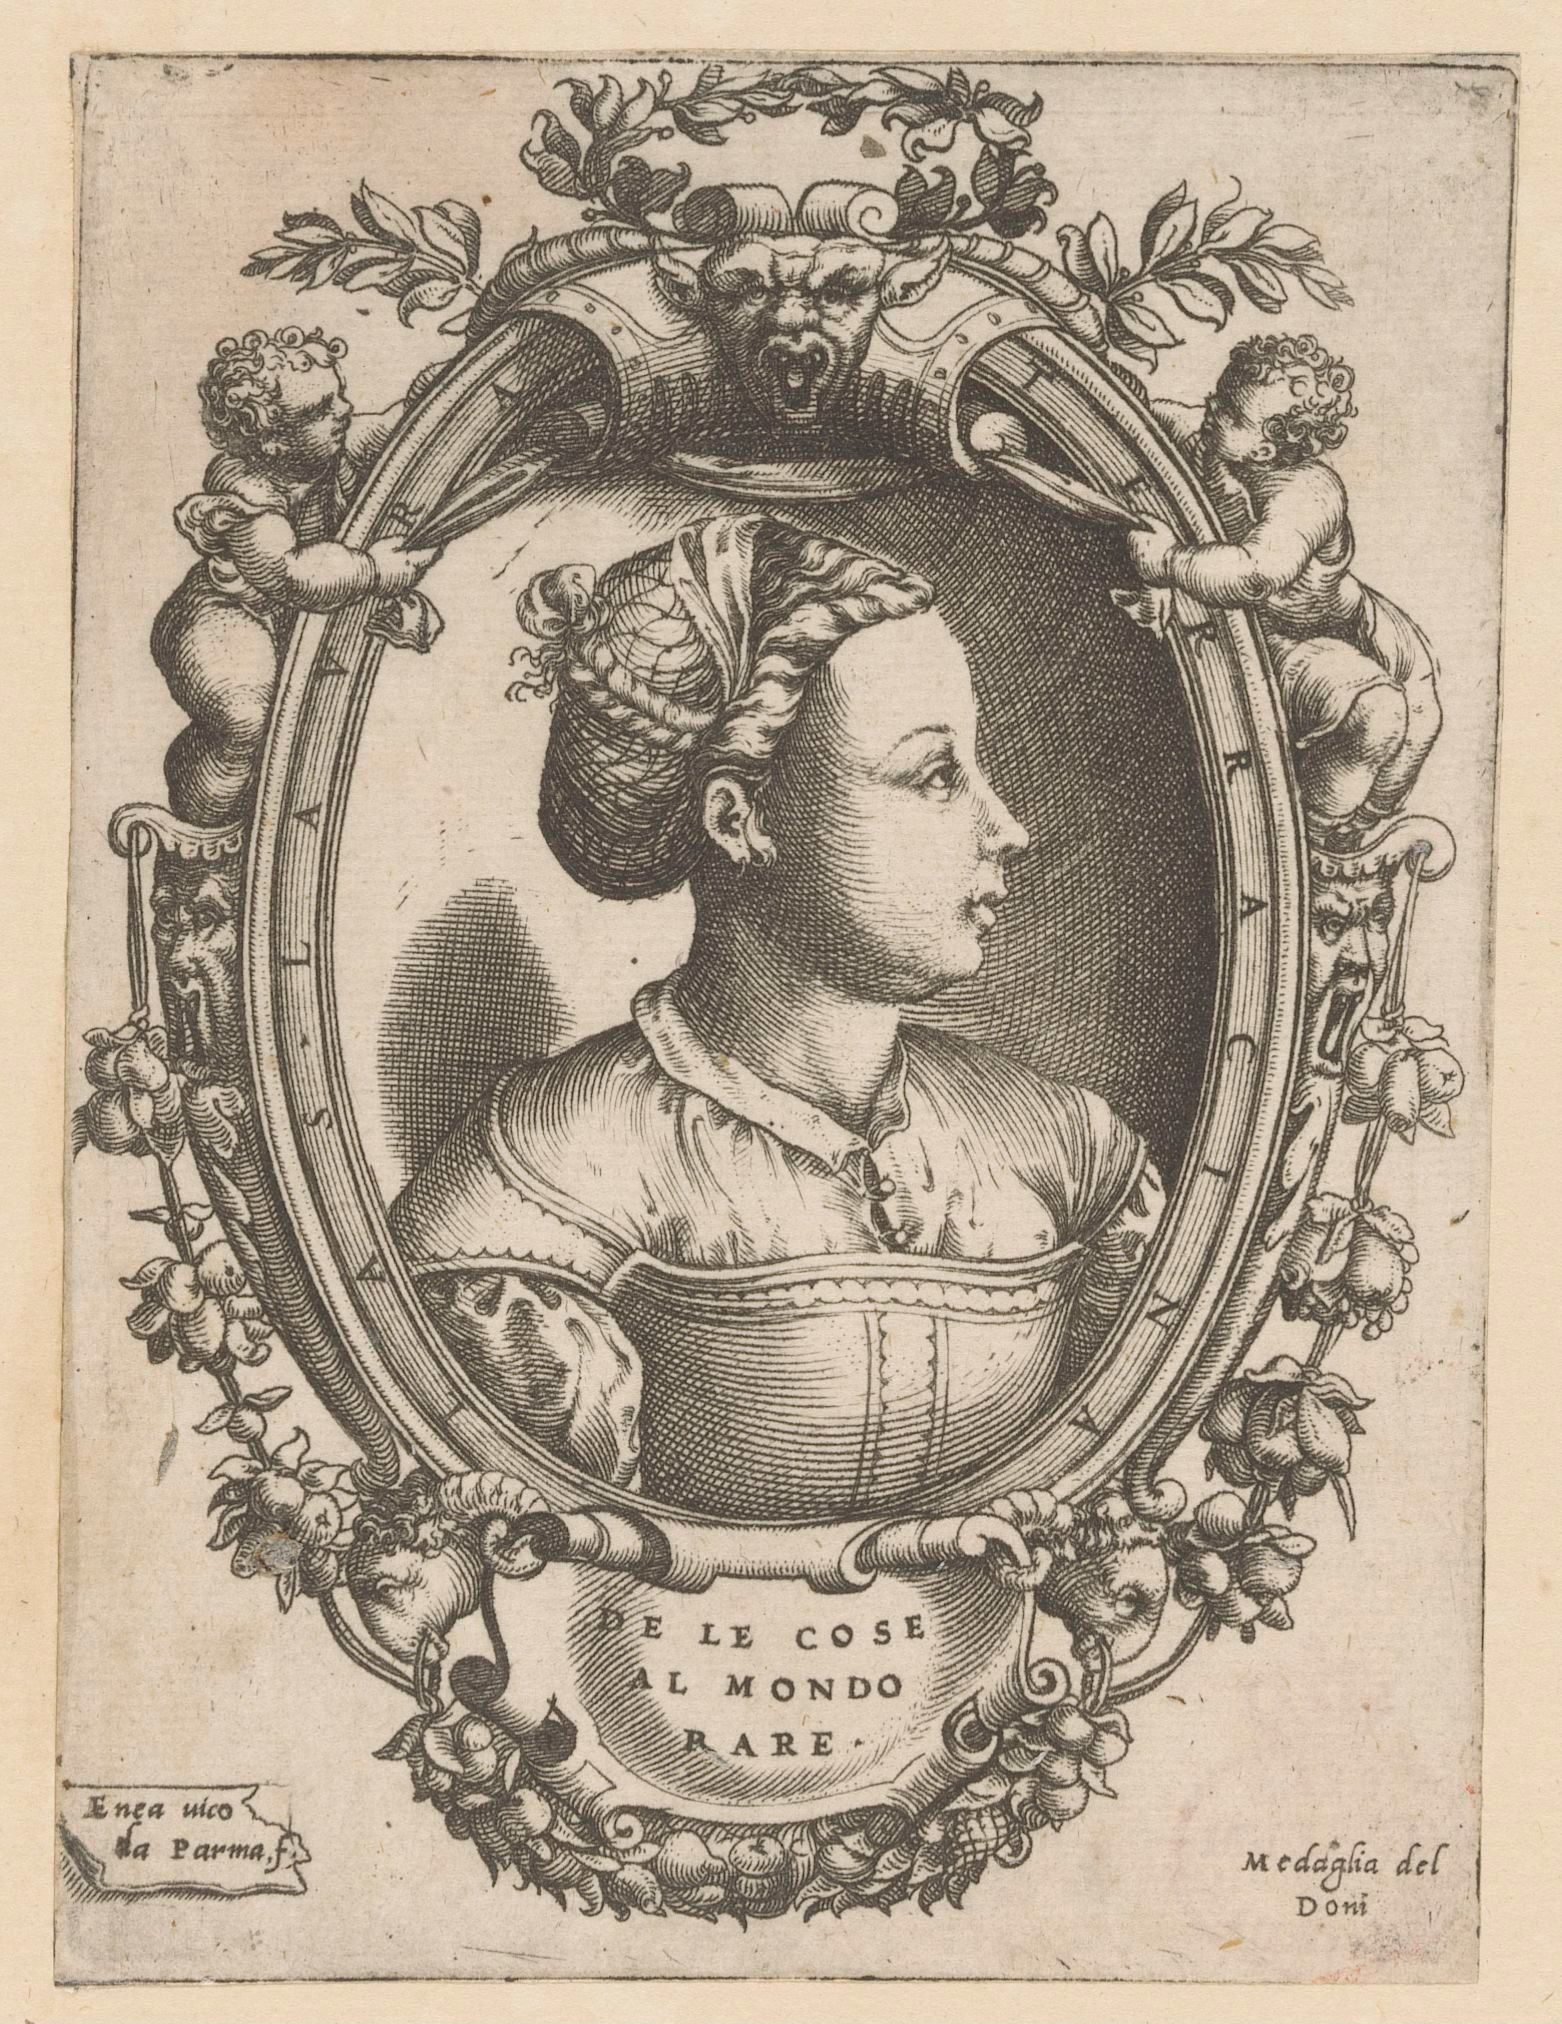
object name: print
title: Portret van dichter Laura Terracina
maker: enea vico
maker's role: draughtsman, print maker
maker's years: 1523-1567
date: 1550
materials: paper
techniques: engraving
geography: italy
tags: naples, historical persons, writer, poet, author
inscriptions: collector's mark: Lugt 12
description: Portret van Laura Terracina, gevat in een geornamenteerde lijst.